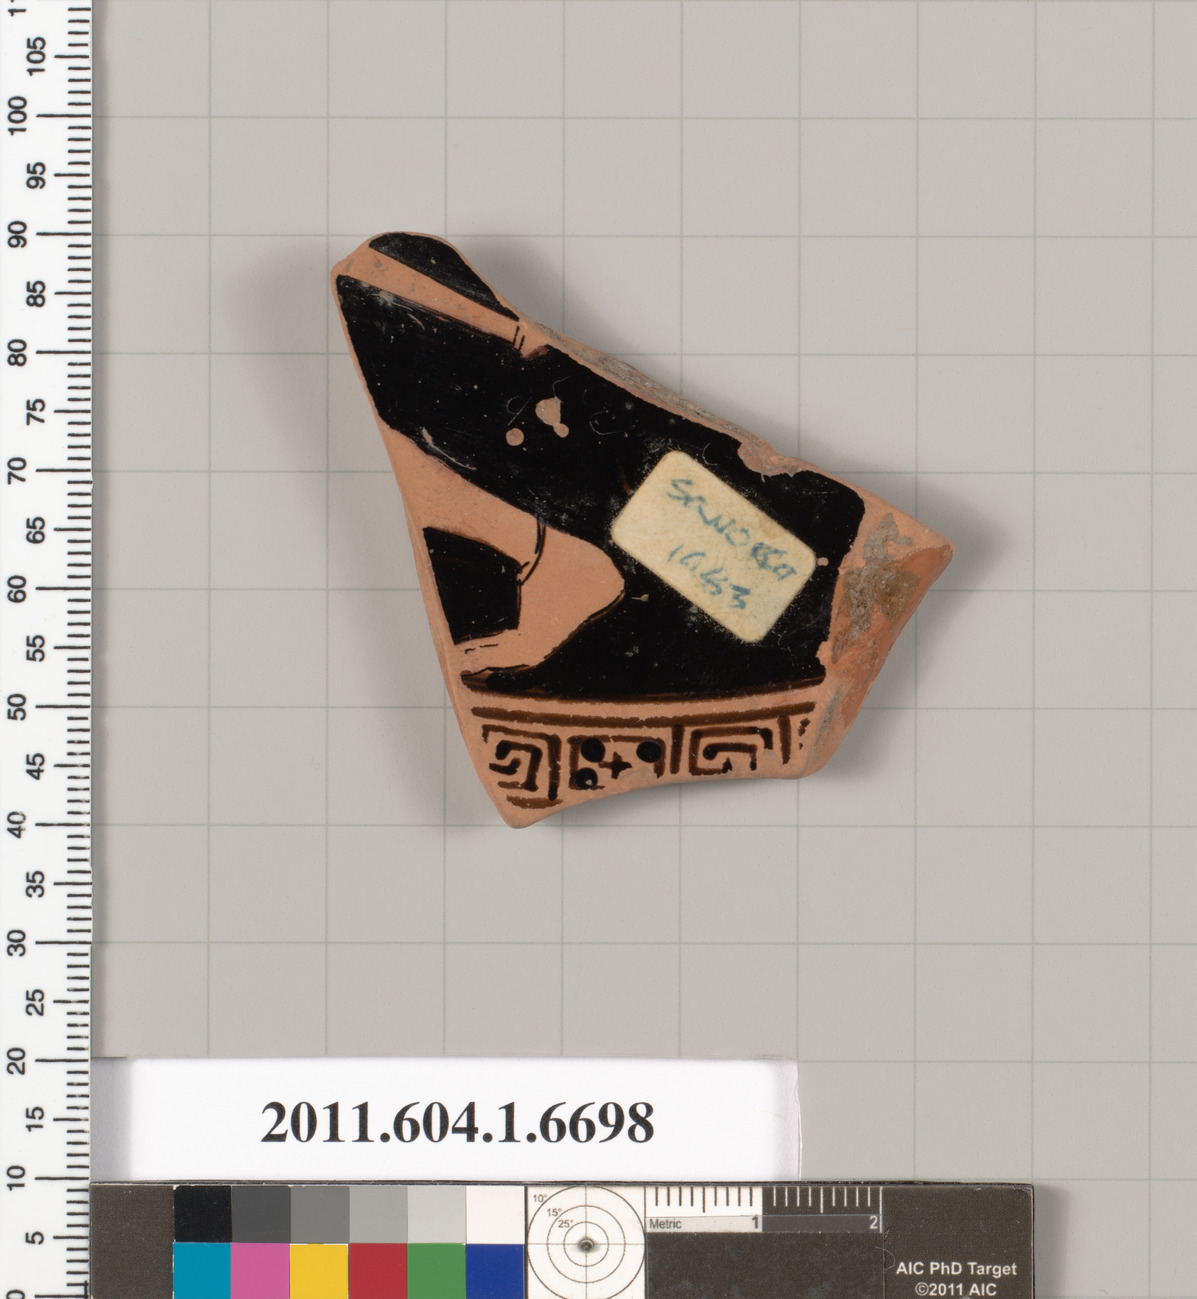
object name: kylix fragment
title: Terracotta fragment of a kylix (drinking cup)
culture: greek, attic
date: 490-470 BCE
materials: terracotta